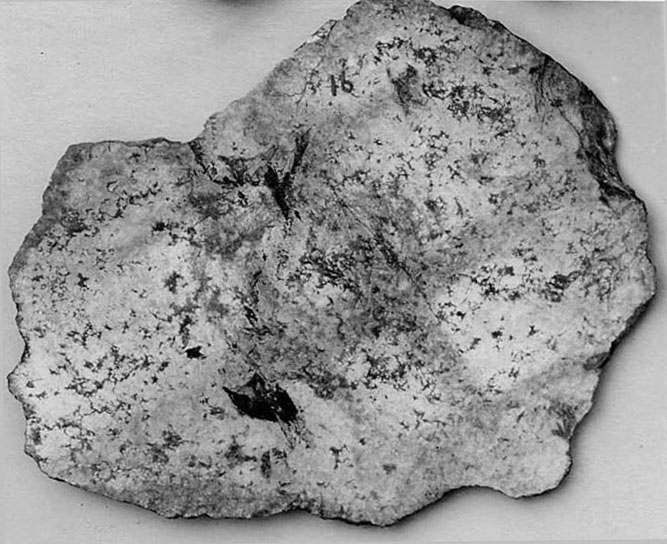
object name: slab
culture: burmese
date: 1902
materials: jade